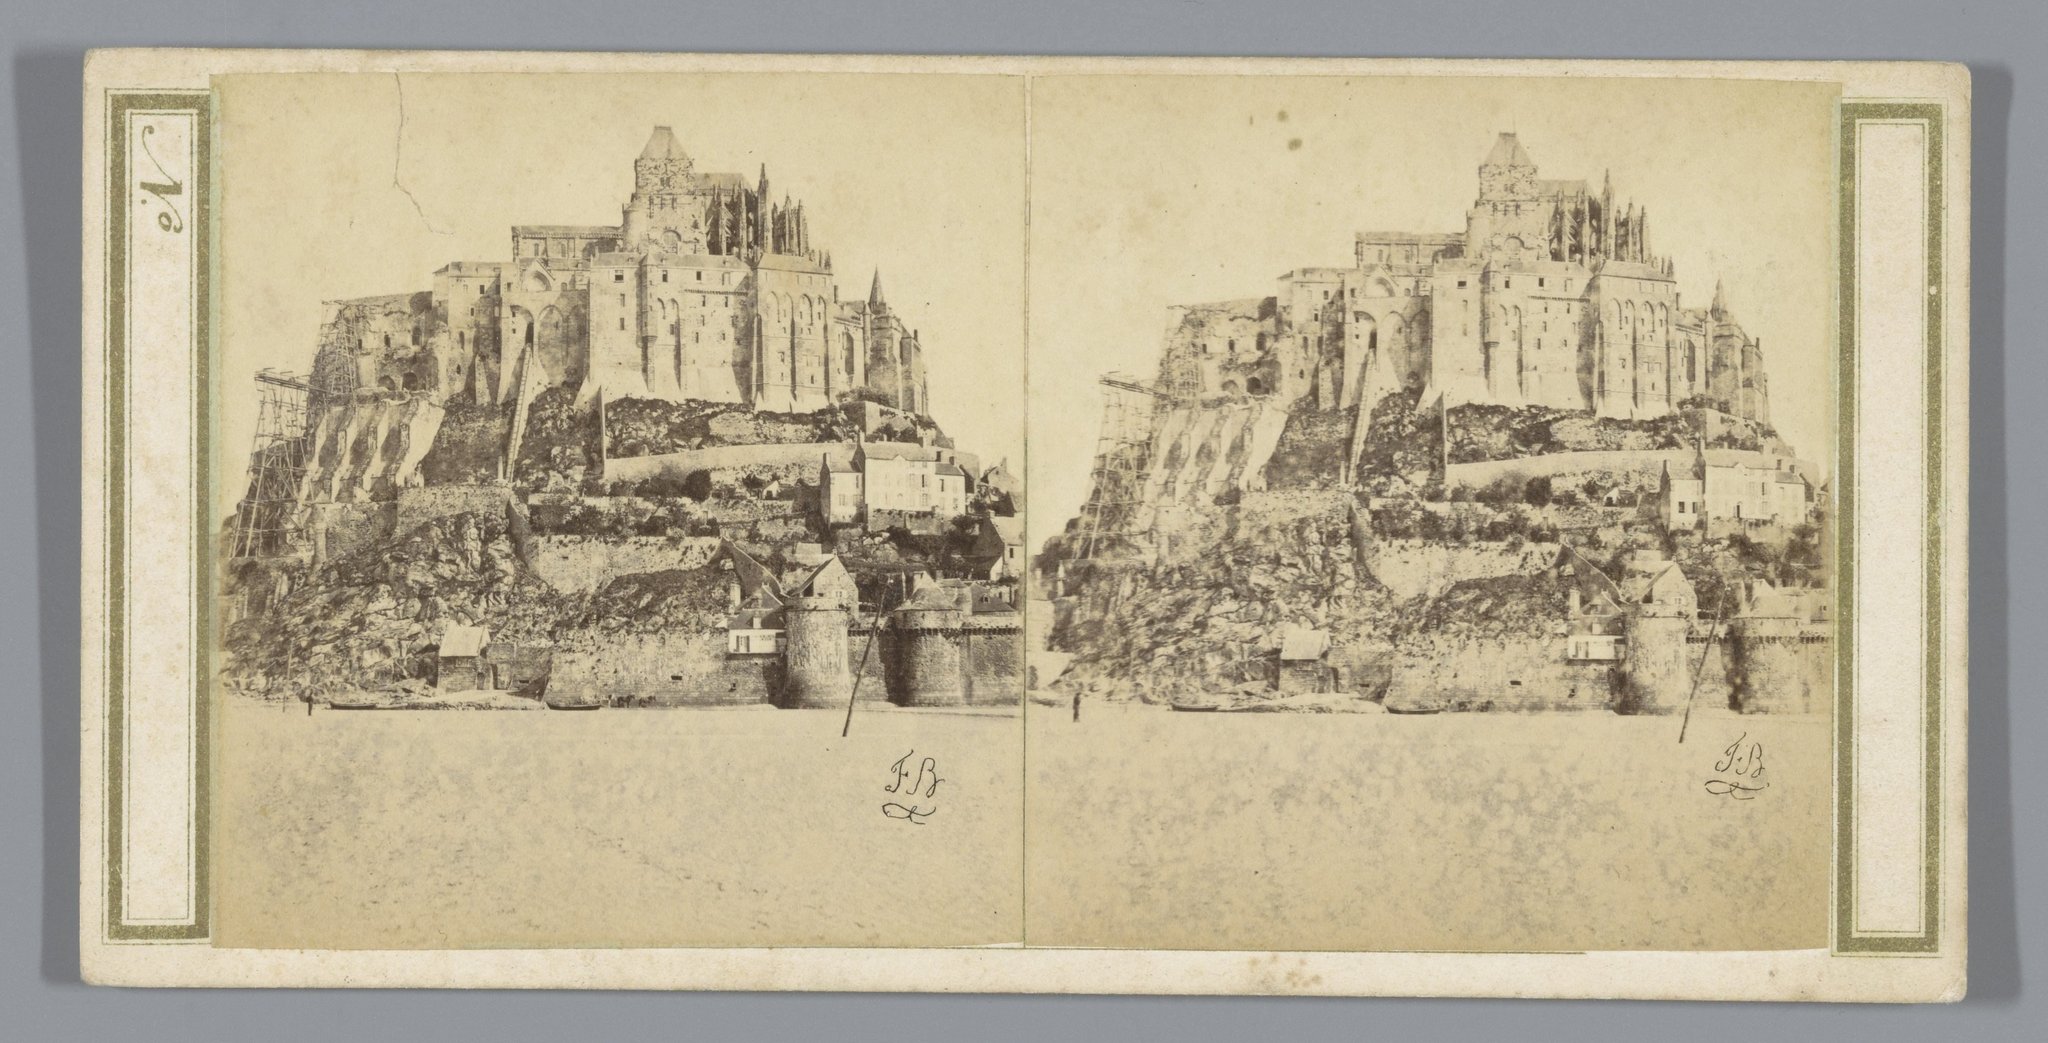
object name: stereograph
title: Gezicht op Mont Saint-Michel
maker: fb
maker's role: fotograaf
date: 1860-1865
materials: cardboard, photographic support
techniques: albumen print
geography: mont-saint-michel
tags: island, abbey, monastery, convent ~ roman catholic church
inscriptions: inscription: ‘Mont Saint Michel’